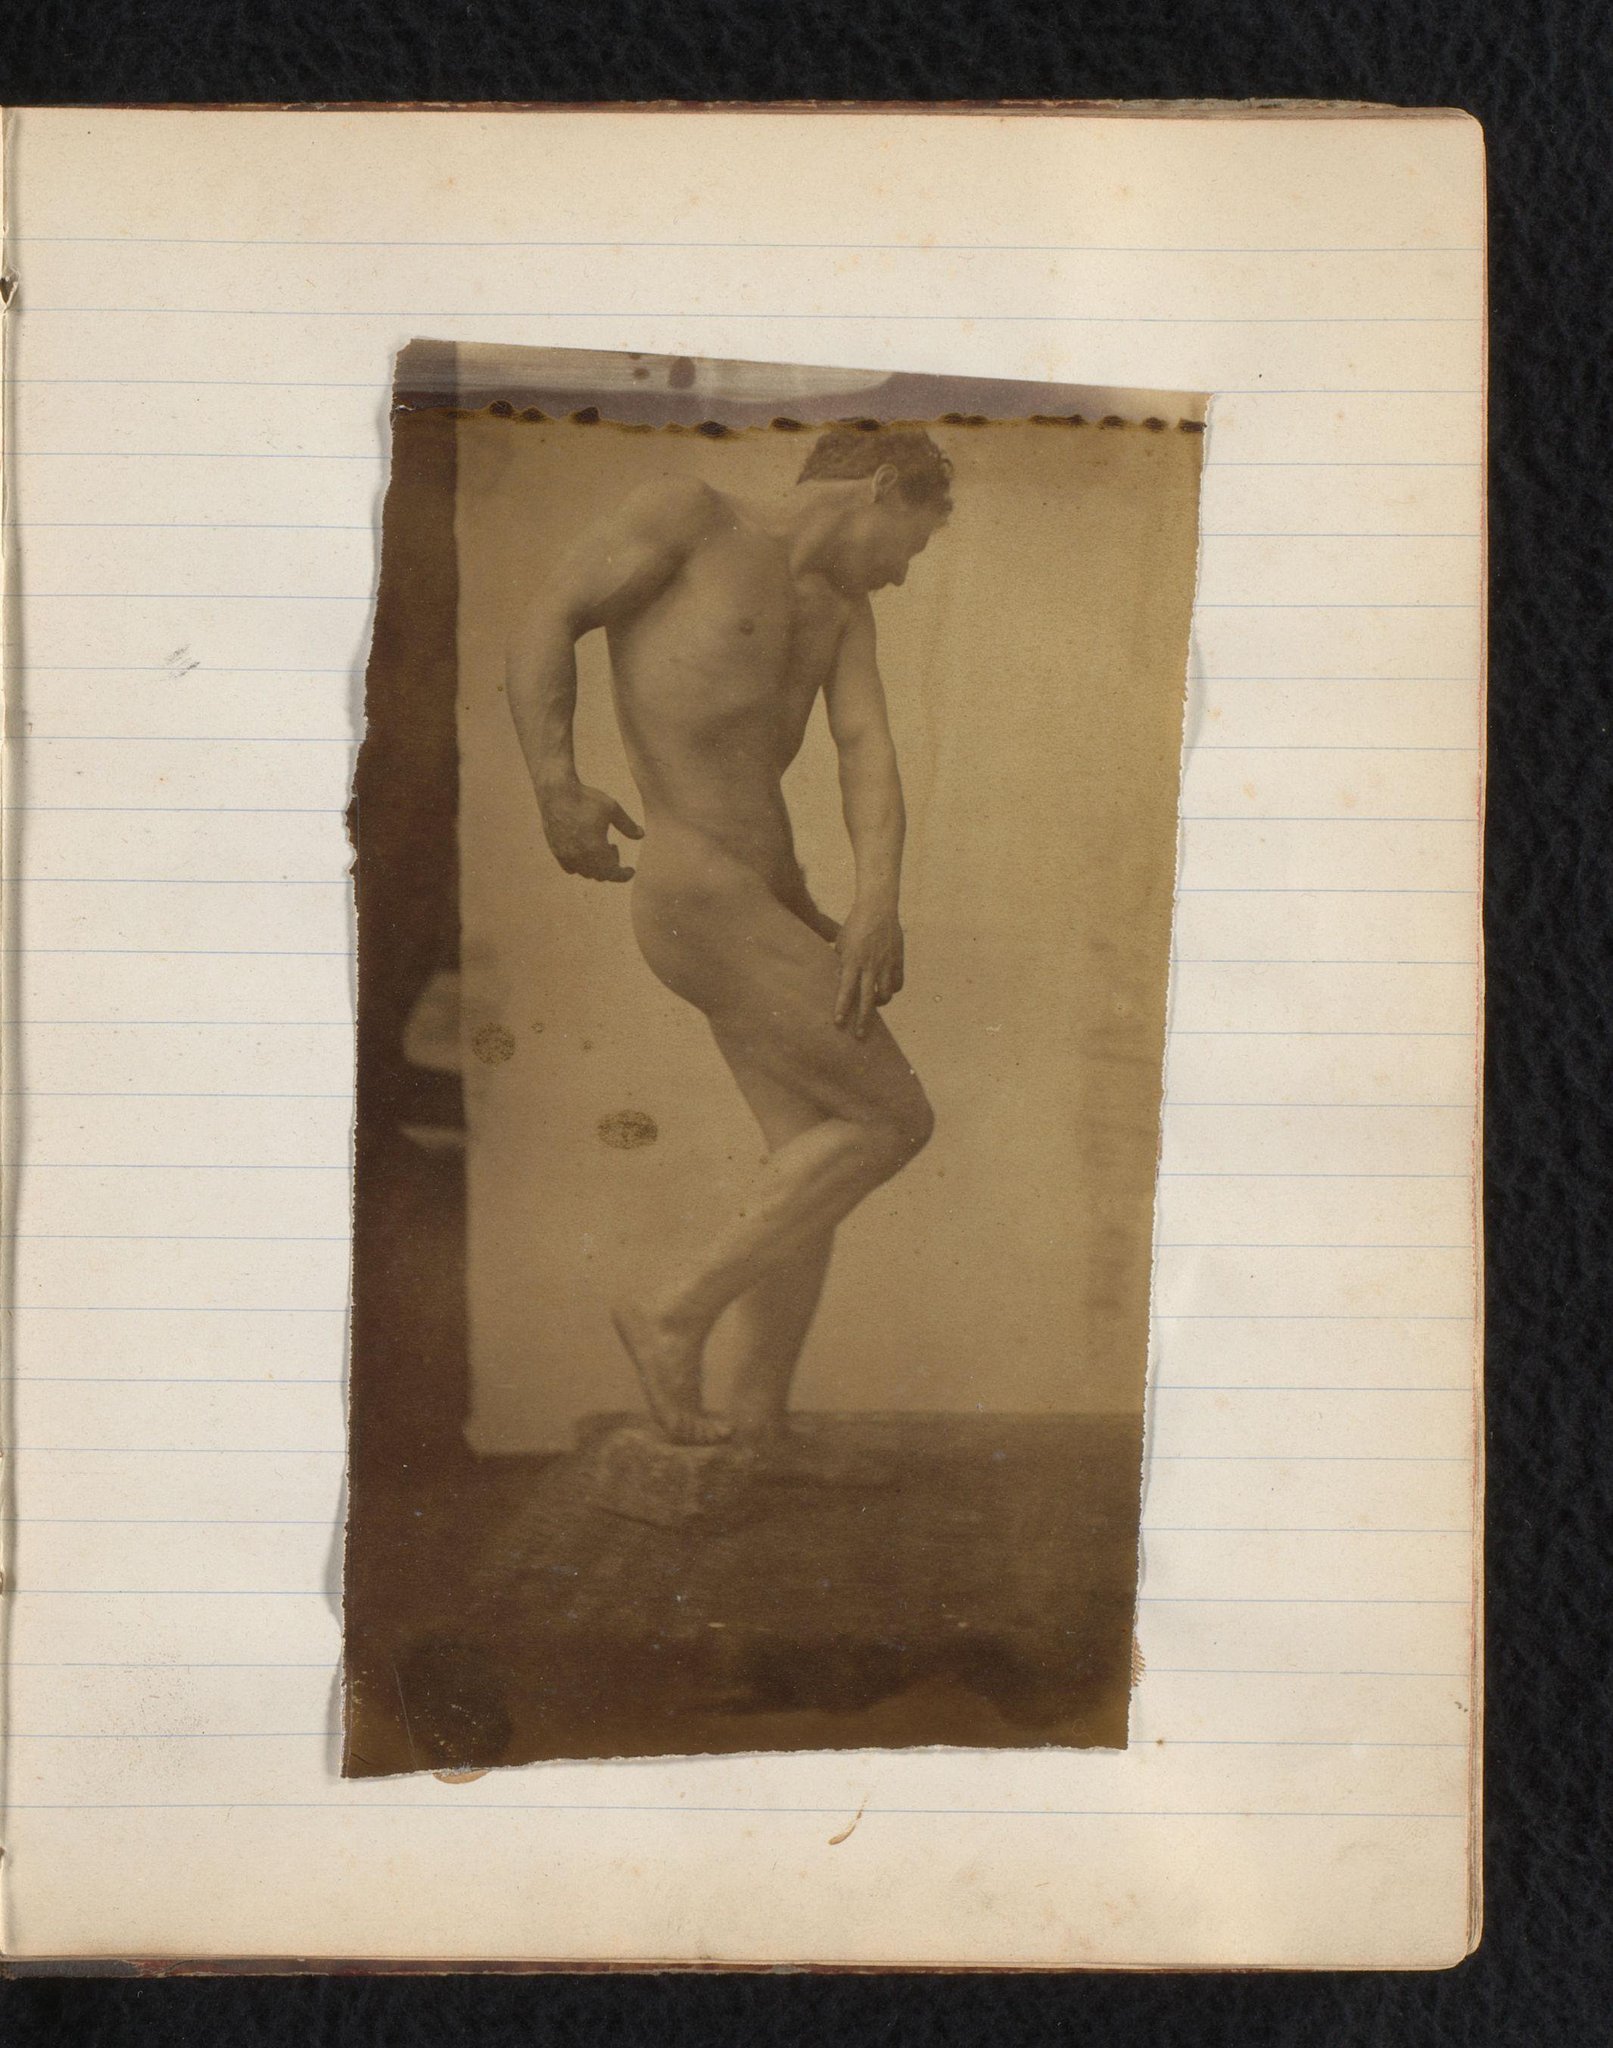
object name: photograph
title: Studie van een mannelijk naaktmodel, staand en van opzij gezien, in het atelier van Jacques de Lalaing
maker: jacques lalaing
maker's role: painter, sculptor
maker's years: 1858-1917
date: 1883-1914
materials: photographic support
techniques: albumen print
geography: brussels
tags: the (nude) human figure; 'corpo humano' (ripa) (+ sideview, profile), adult man, artist (in general) working from nude model